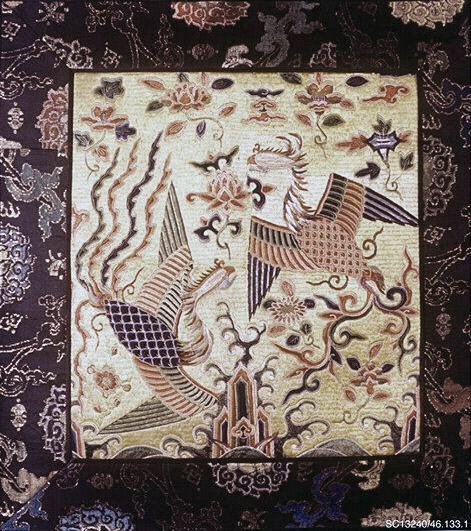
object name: square with phoenix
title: Square with Phoenixes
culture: chinese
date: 1567-1633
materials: metal thread, silk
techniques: embroidery, weave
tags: birds